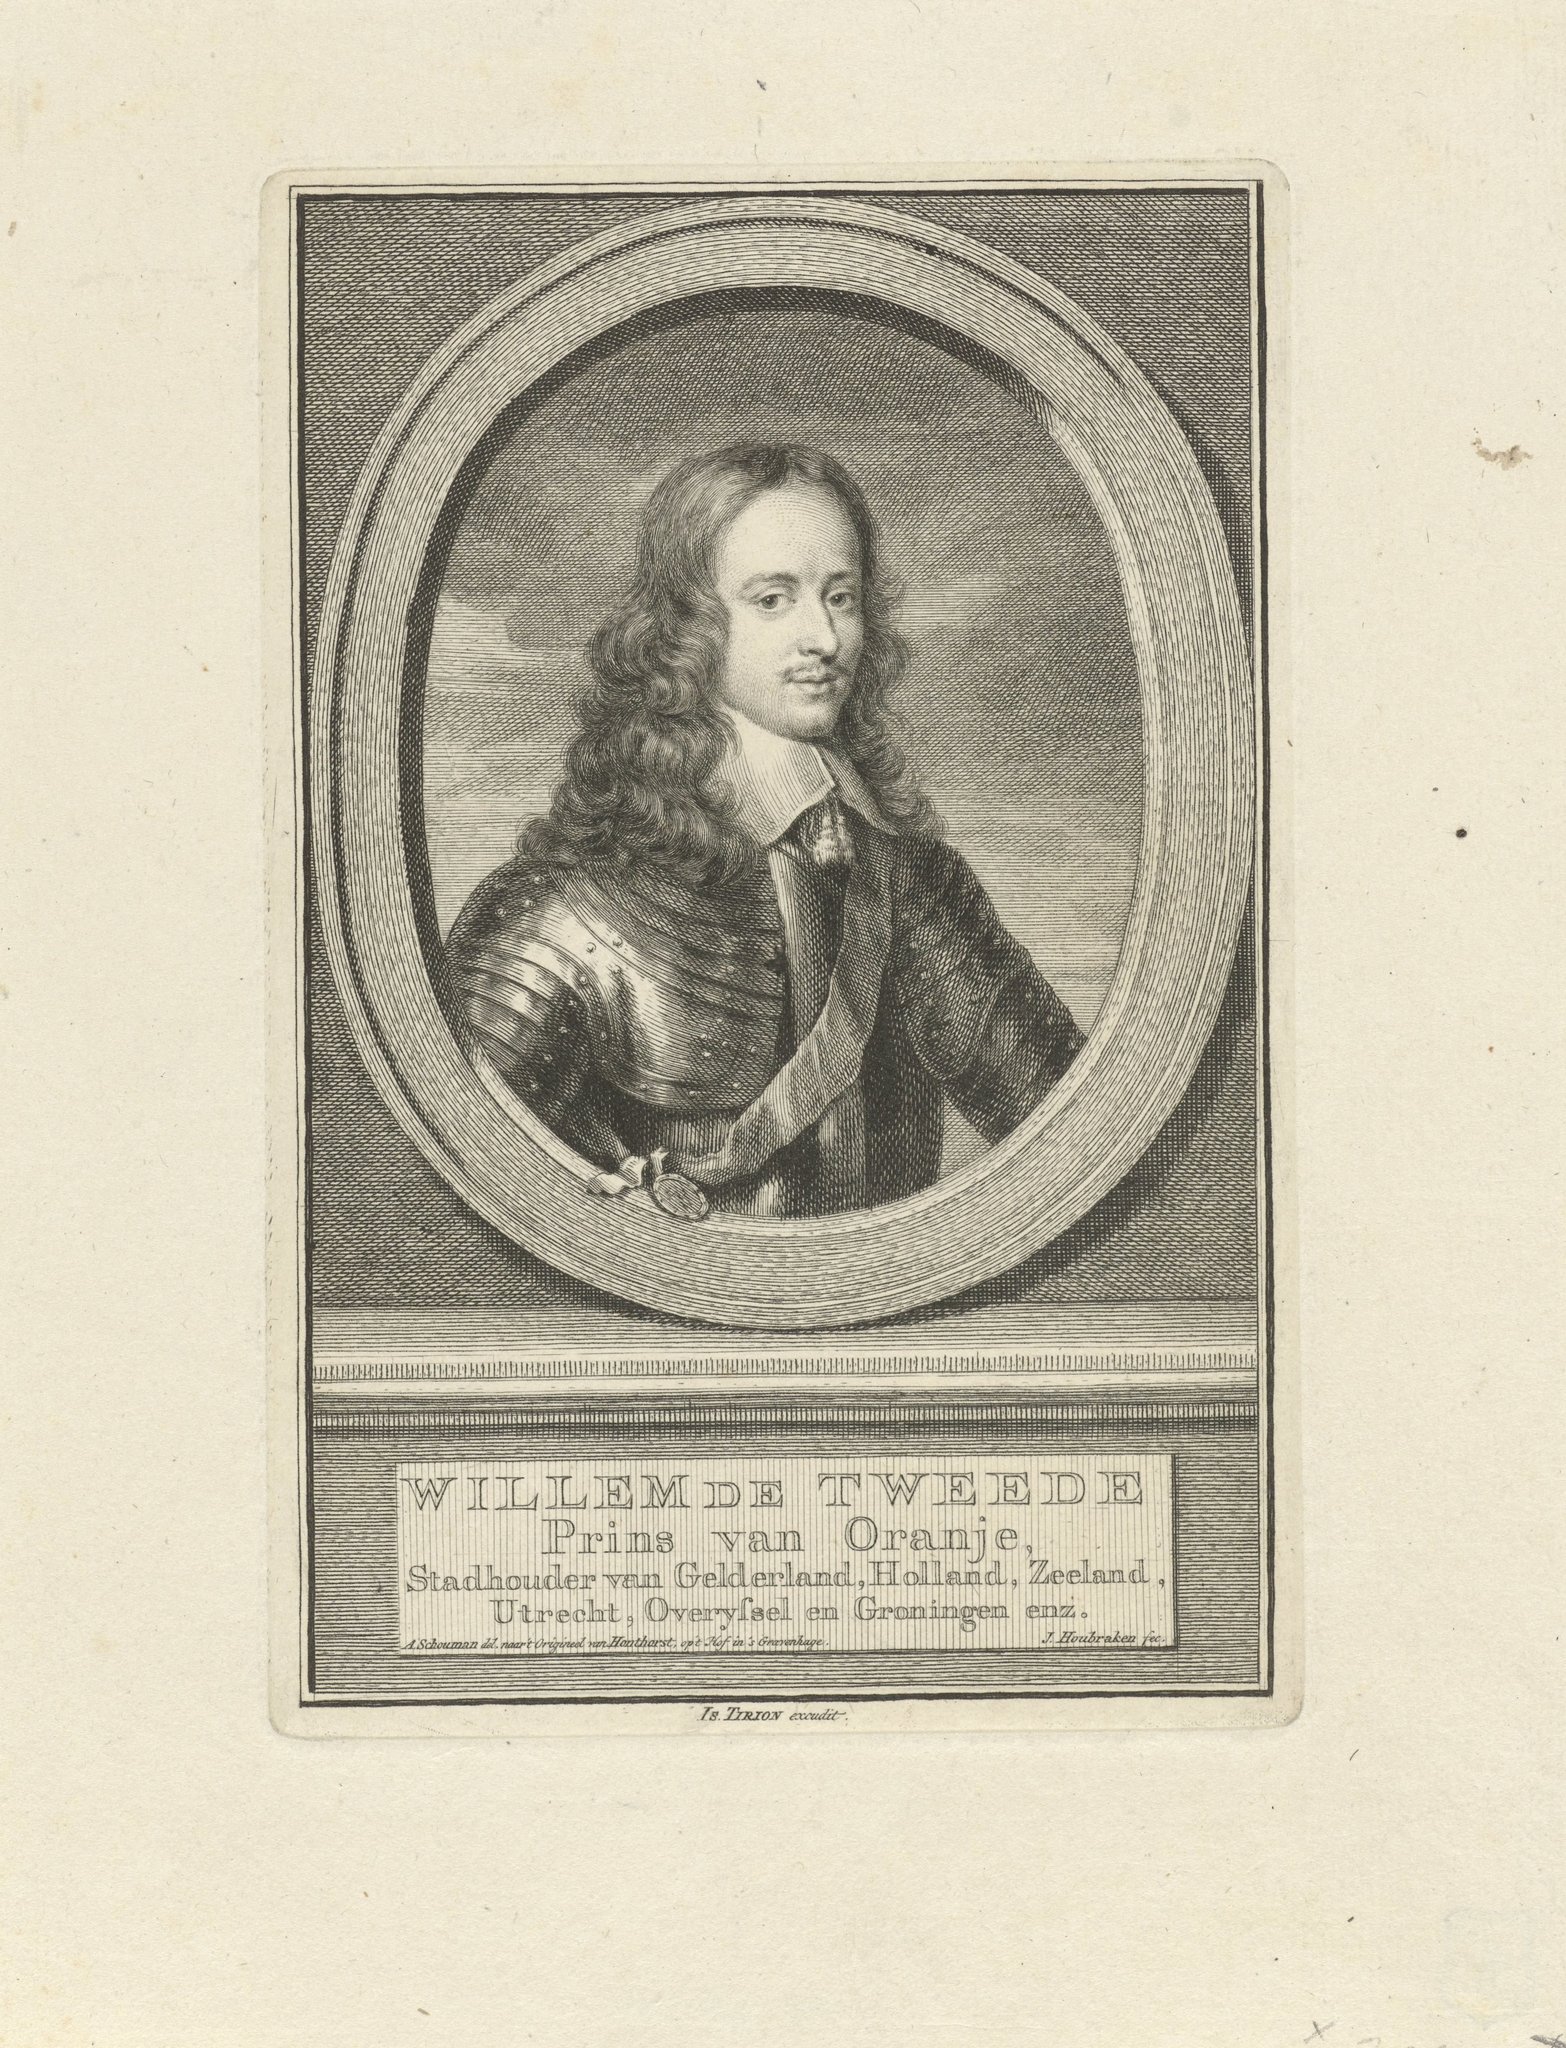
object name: print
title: Willem de Tweede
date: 1749-1759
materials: paper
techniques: engraving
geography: amsterdam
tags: william ii (prince of orange)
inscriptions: collector's mark: Lugt 963, collector's mark: Lugt 2228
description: Prent ook gebruikt in: Jan Wagenaar, Vaderlandsche historie, vervattende de geschiedenissen der nu Vereenigde Nederlanden, inzonderheid die van Holland (...), 21 delen. Amsterdam, Isaak Tirion, 1749-59.